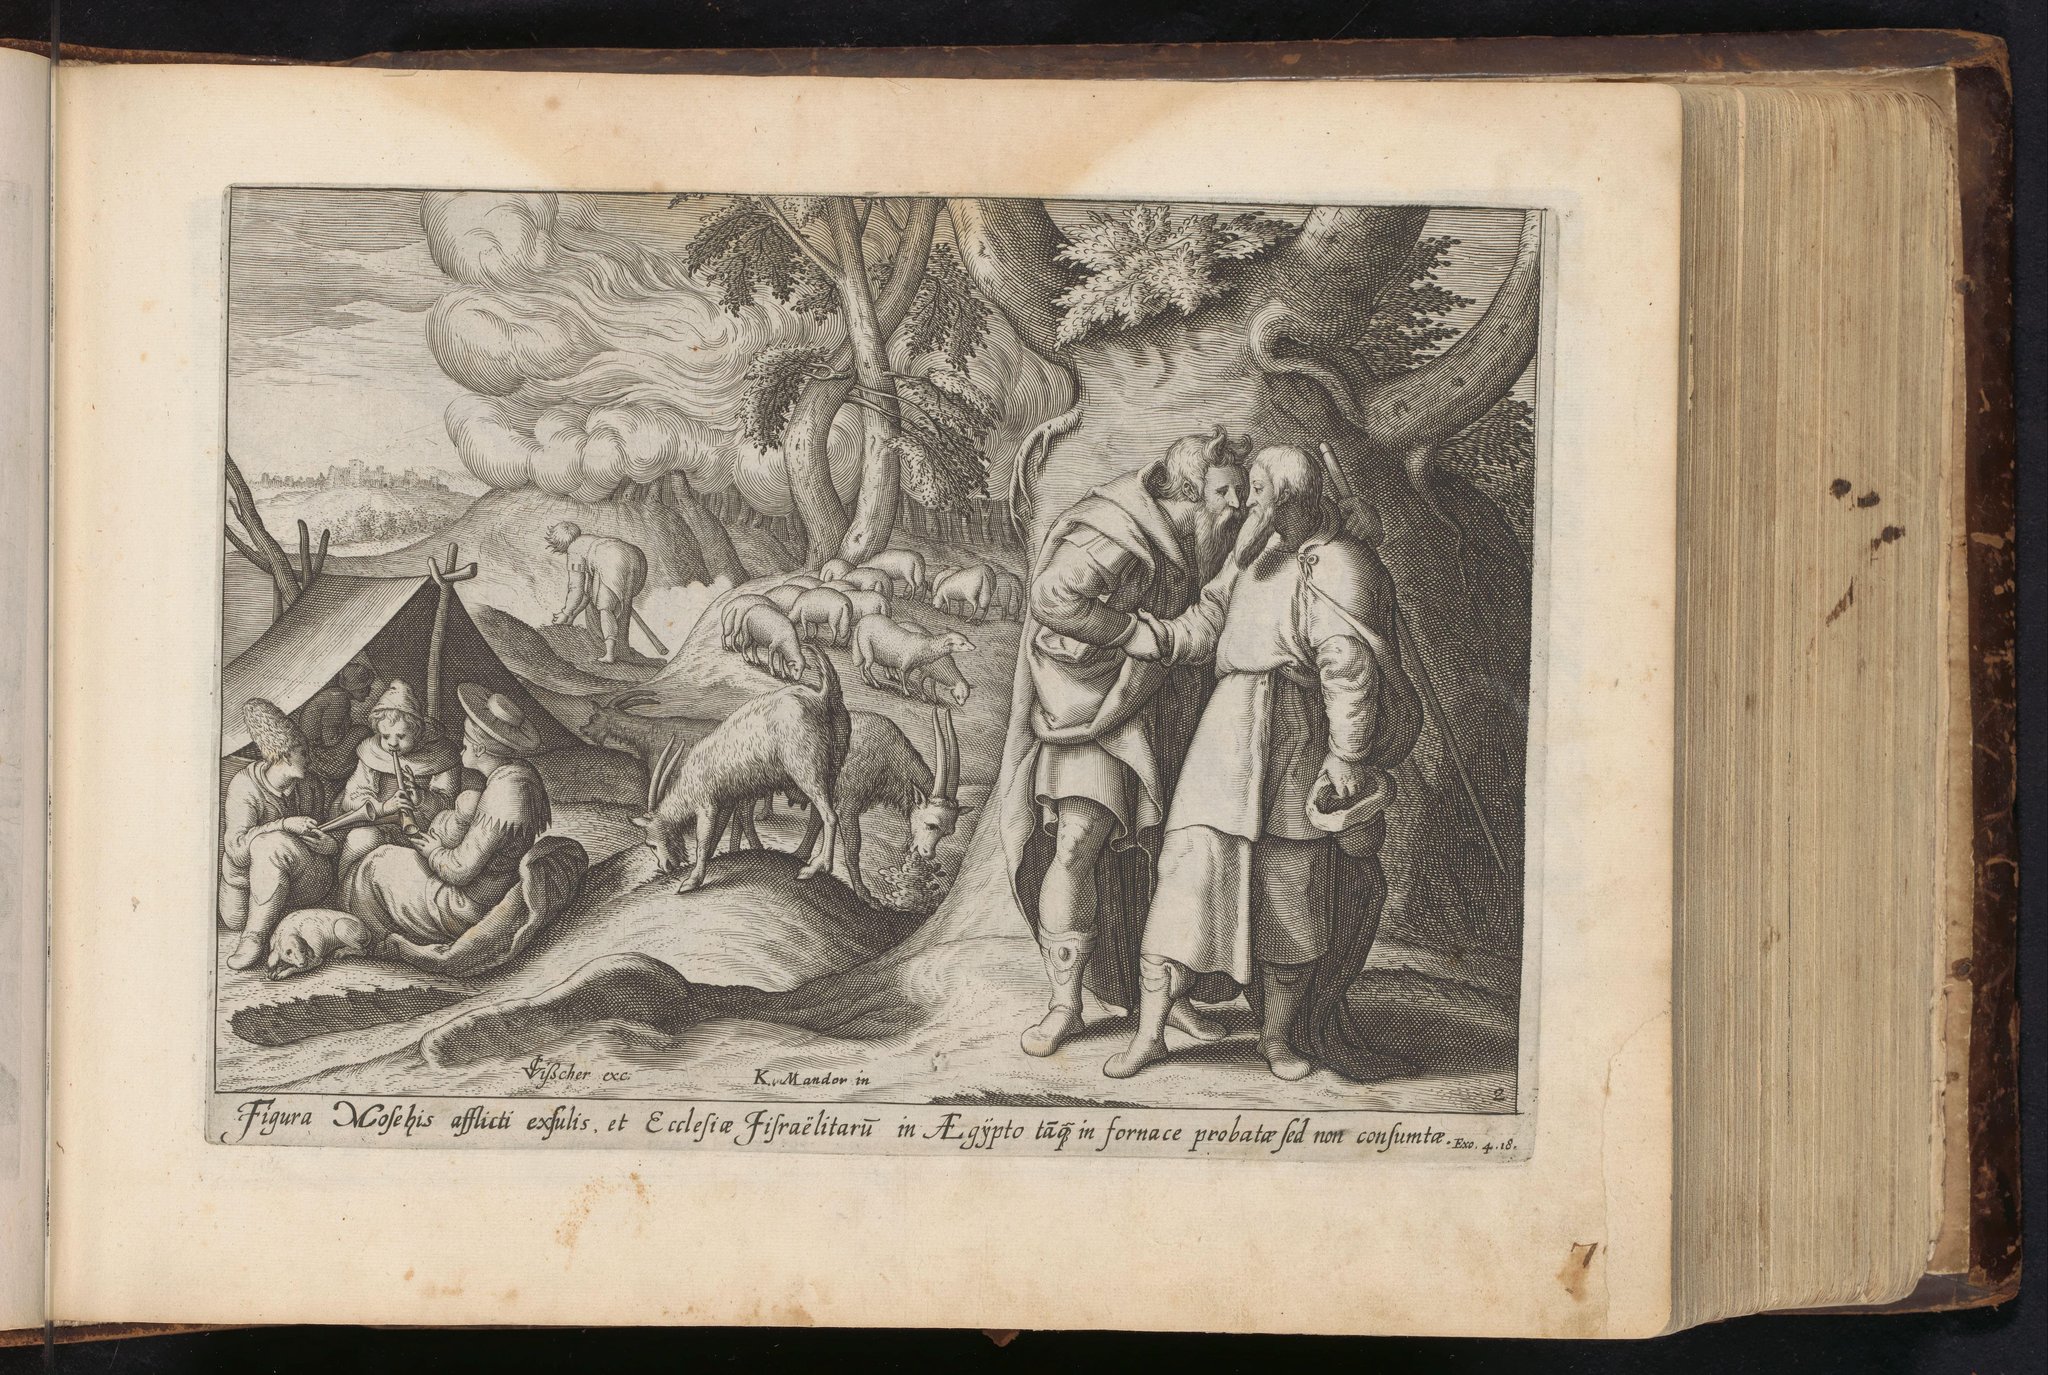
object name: print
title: Mozes en Jetro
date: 1588-1592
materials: paper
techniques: engraving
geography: amsterdam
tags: moses and jethro parting ~ the calling of moses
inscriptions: number: ‘77’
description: Mozes neemt afscheid van zijn schoonvader Jetro om terug naar Egypte te gaan. Links herders. Onder de voorstelling een verwijzing in het Latijn naar de Bijbeltekst in Ex. 4:18. Deze prent maakt deel uit van een album.